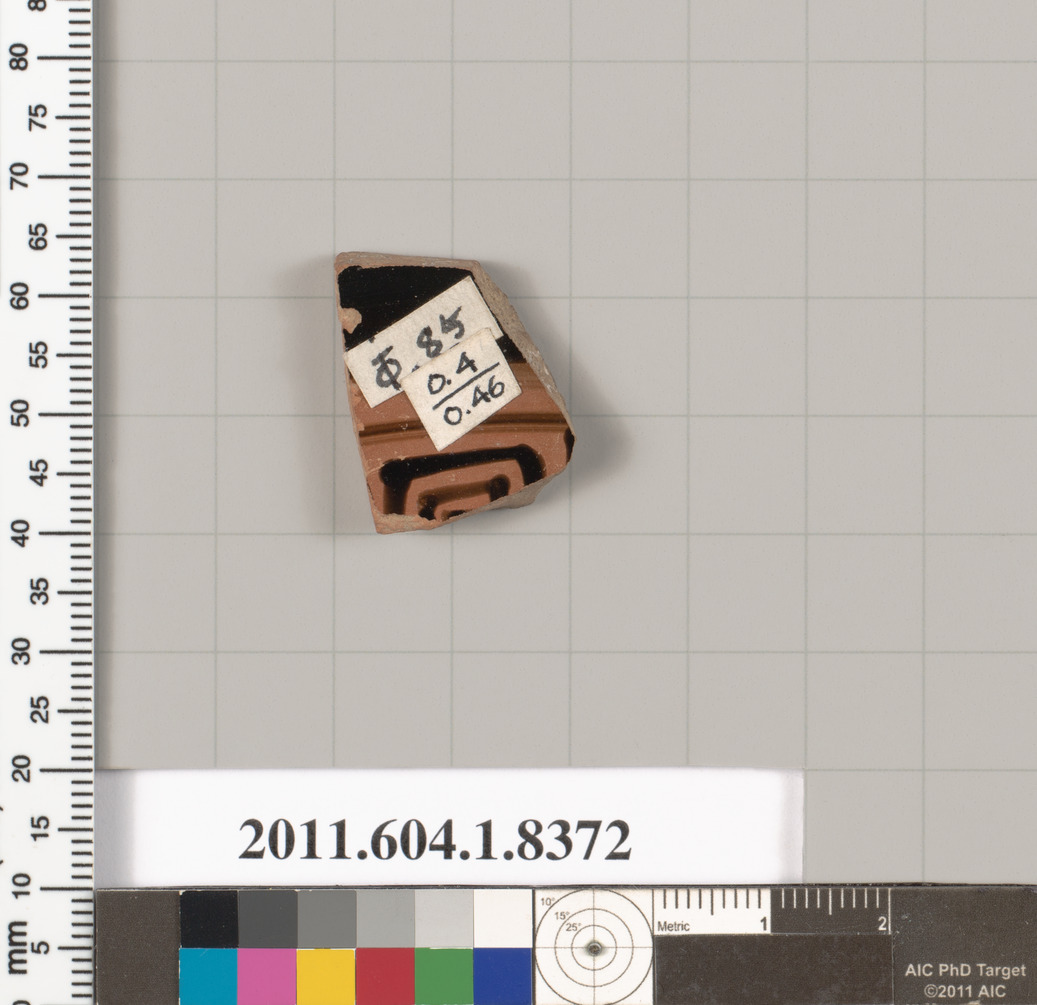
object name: kylix fragment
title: Terracotta fragment of a kylix (drinking cup)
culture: greek, attic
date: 400-351 BCE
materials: terracotta